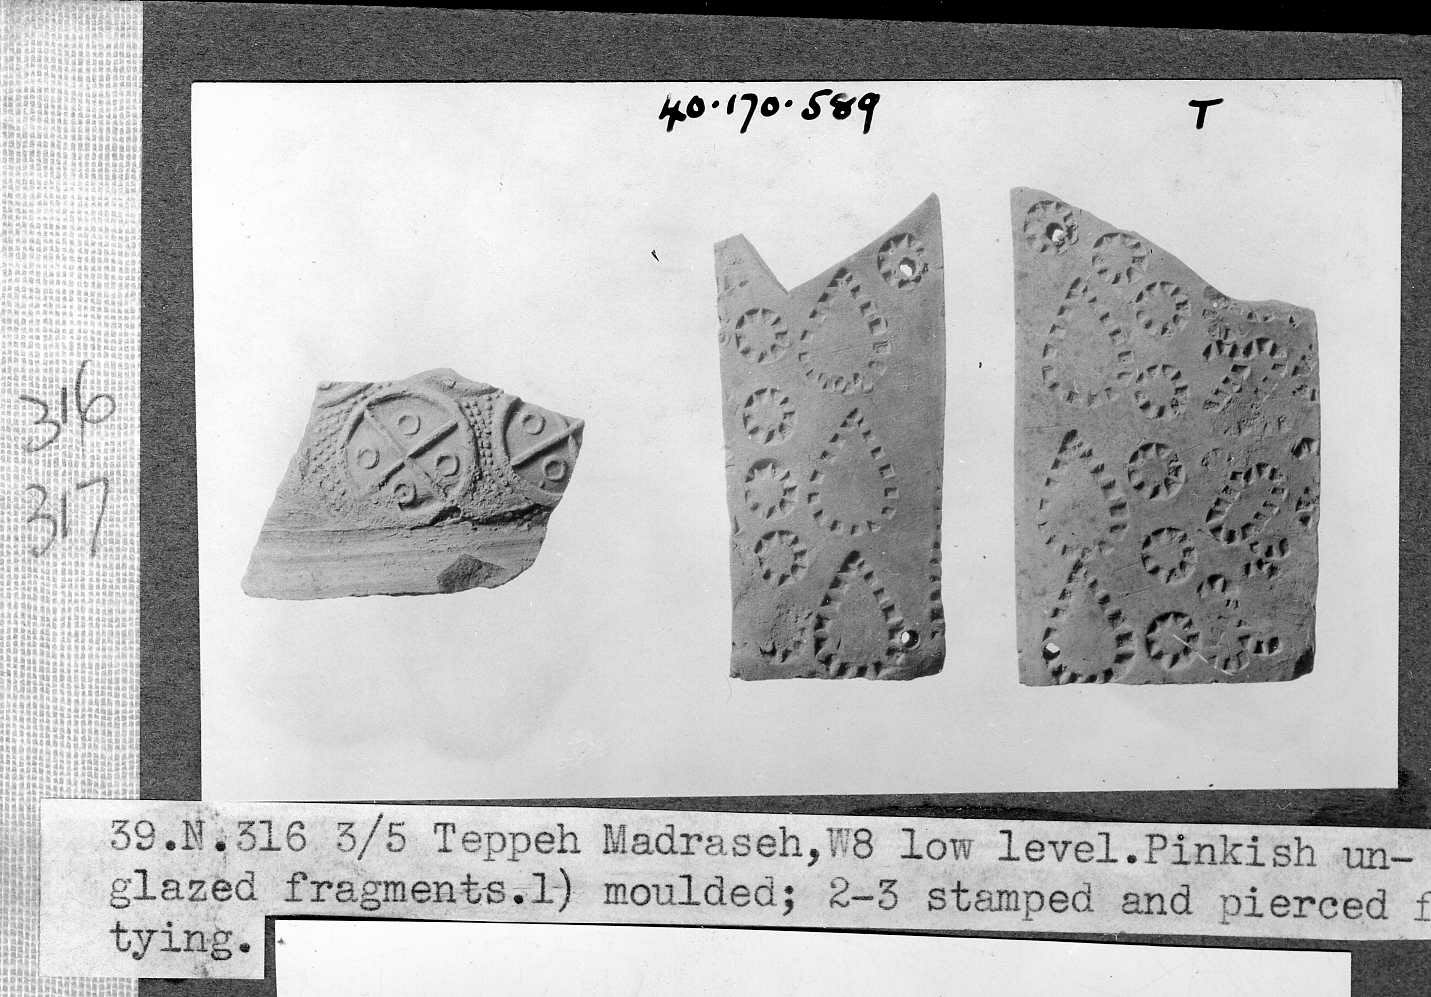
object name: fragment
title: Ceramic Fragment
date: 801-1000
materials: earthenware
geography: iran